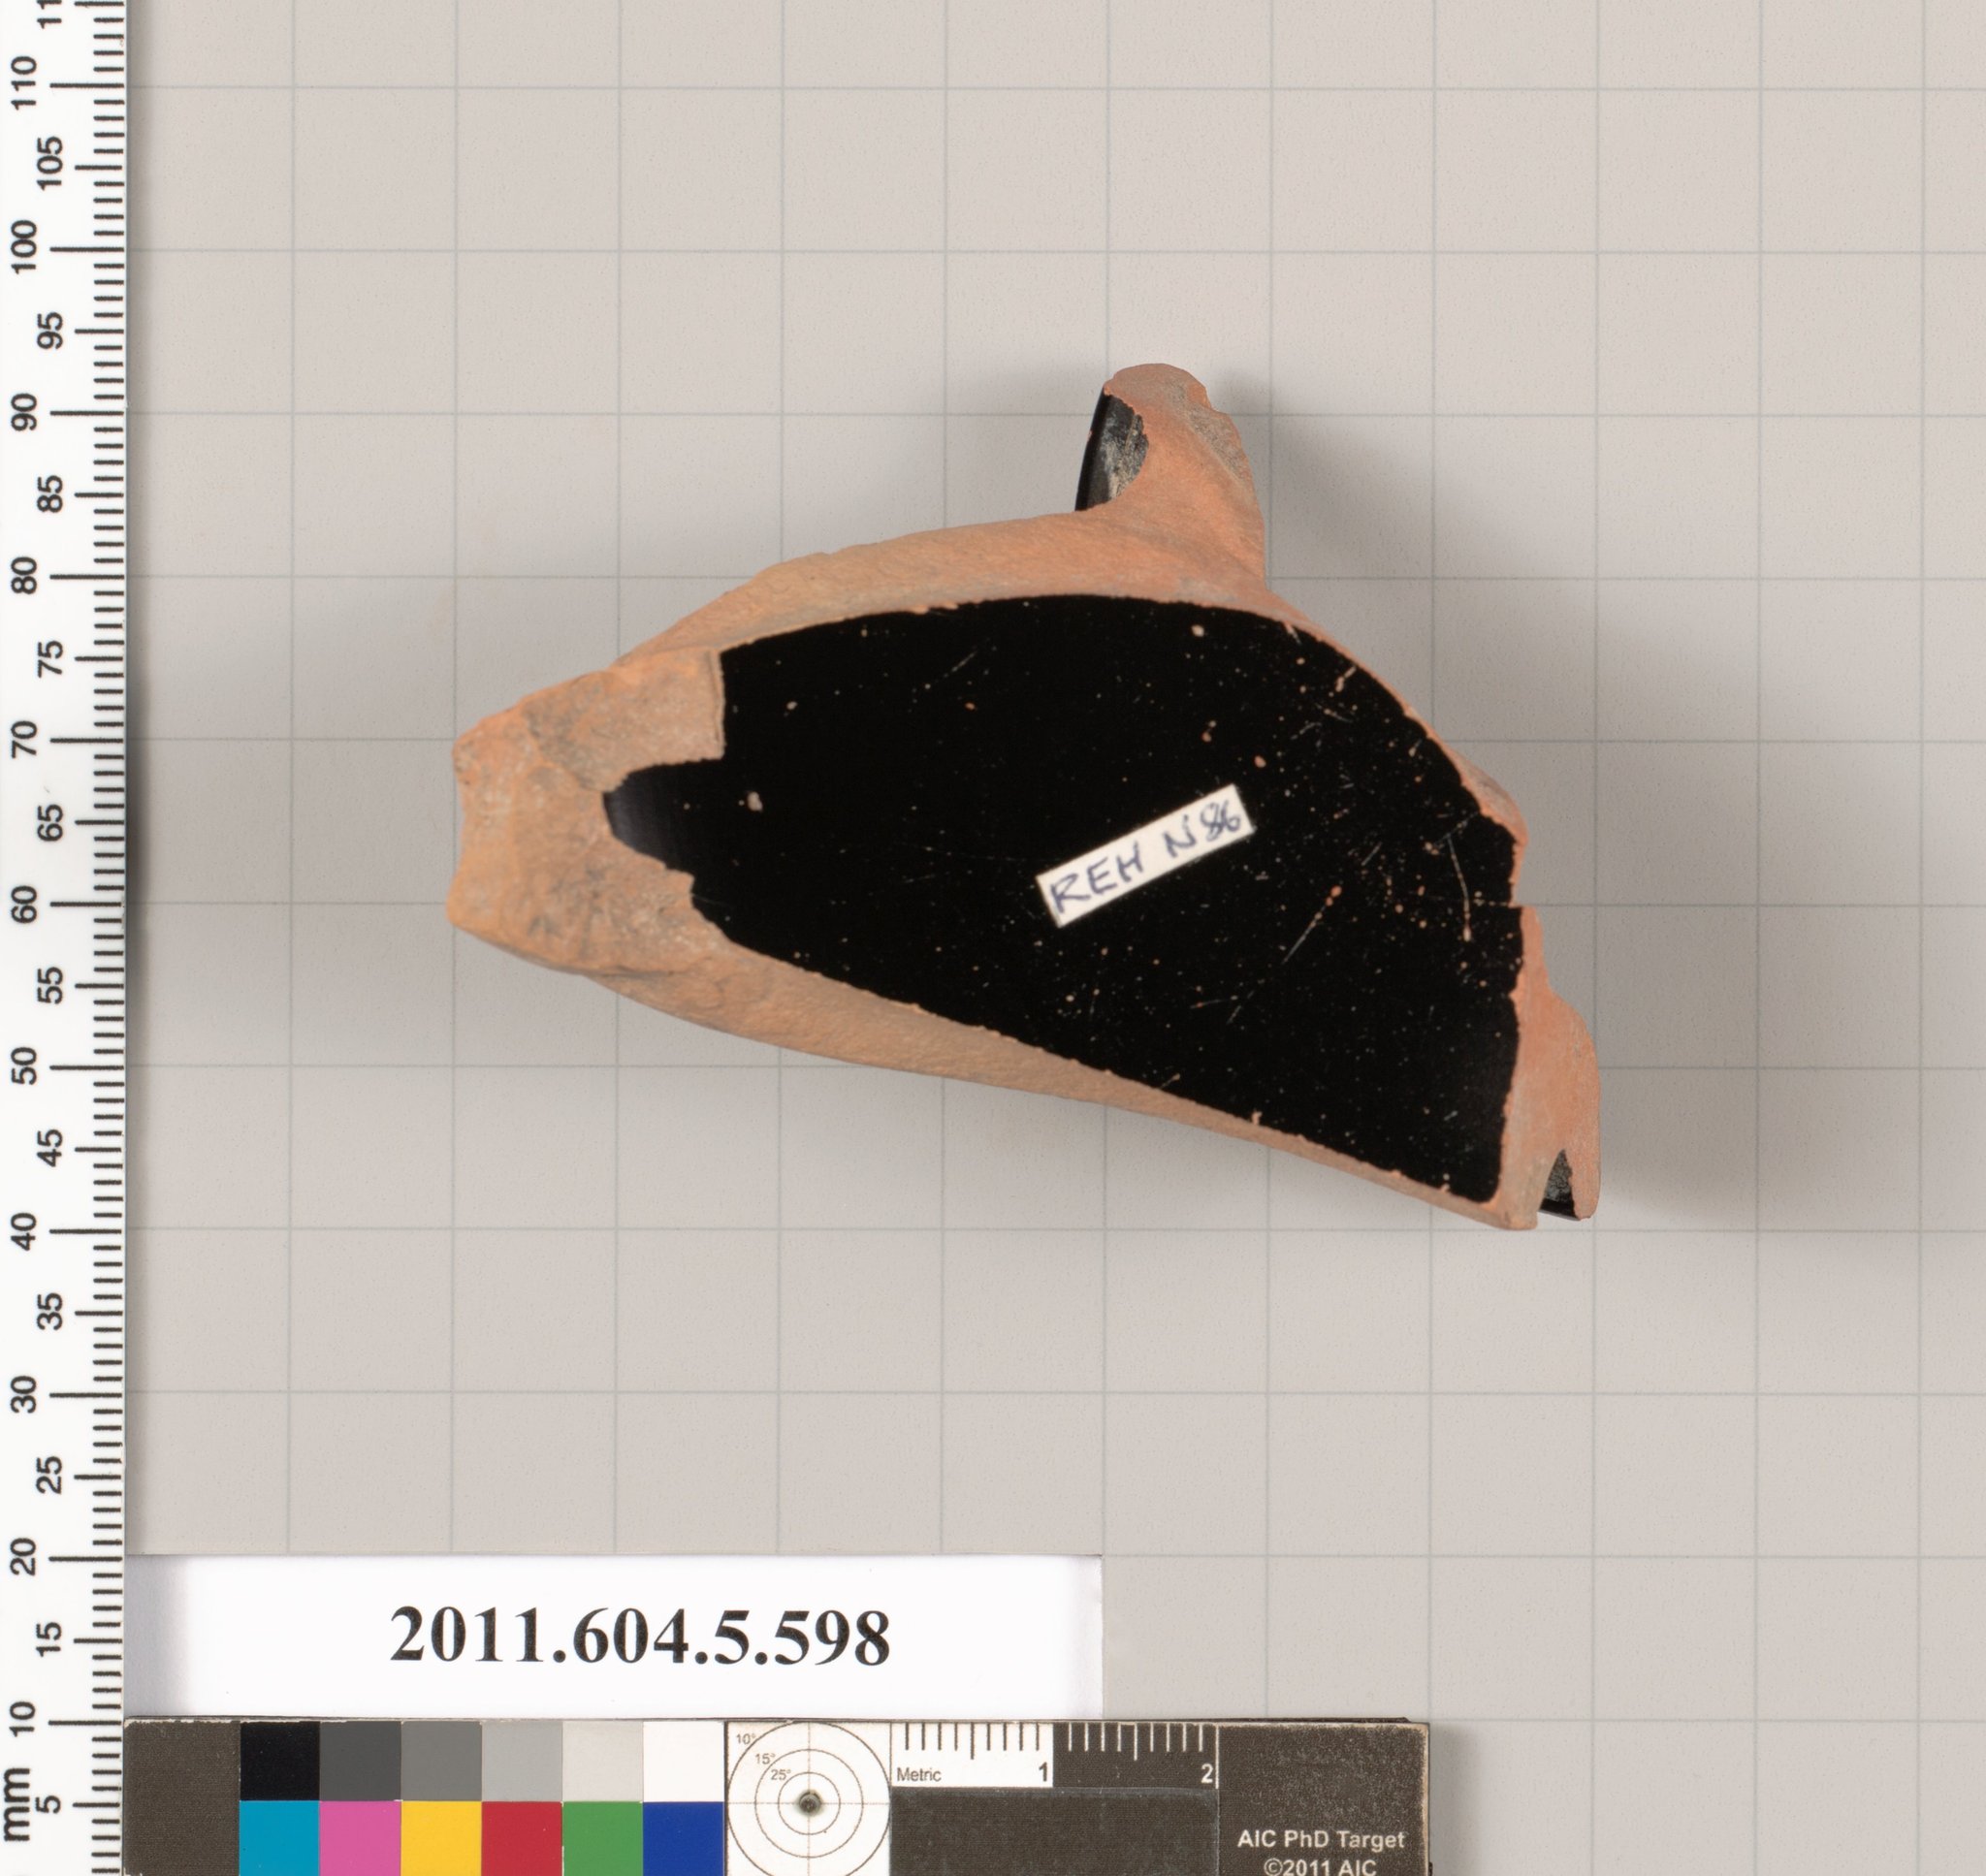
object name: stemless kylix fragment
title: Terracotta fragment of a stemless kylix (drinking cup)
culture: greek, attic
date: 500-401 BCE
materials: terracotta